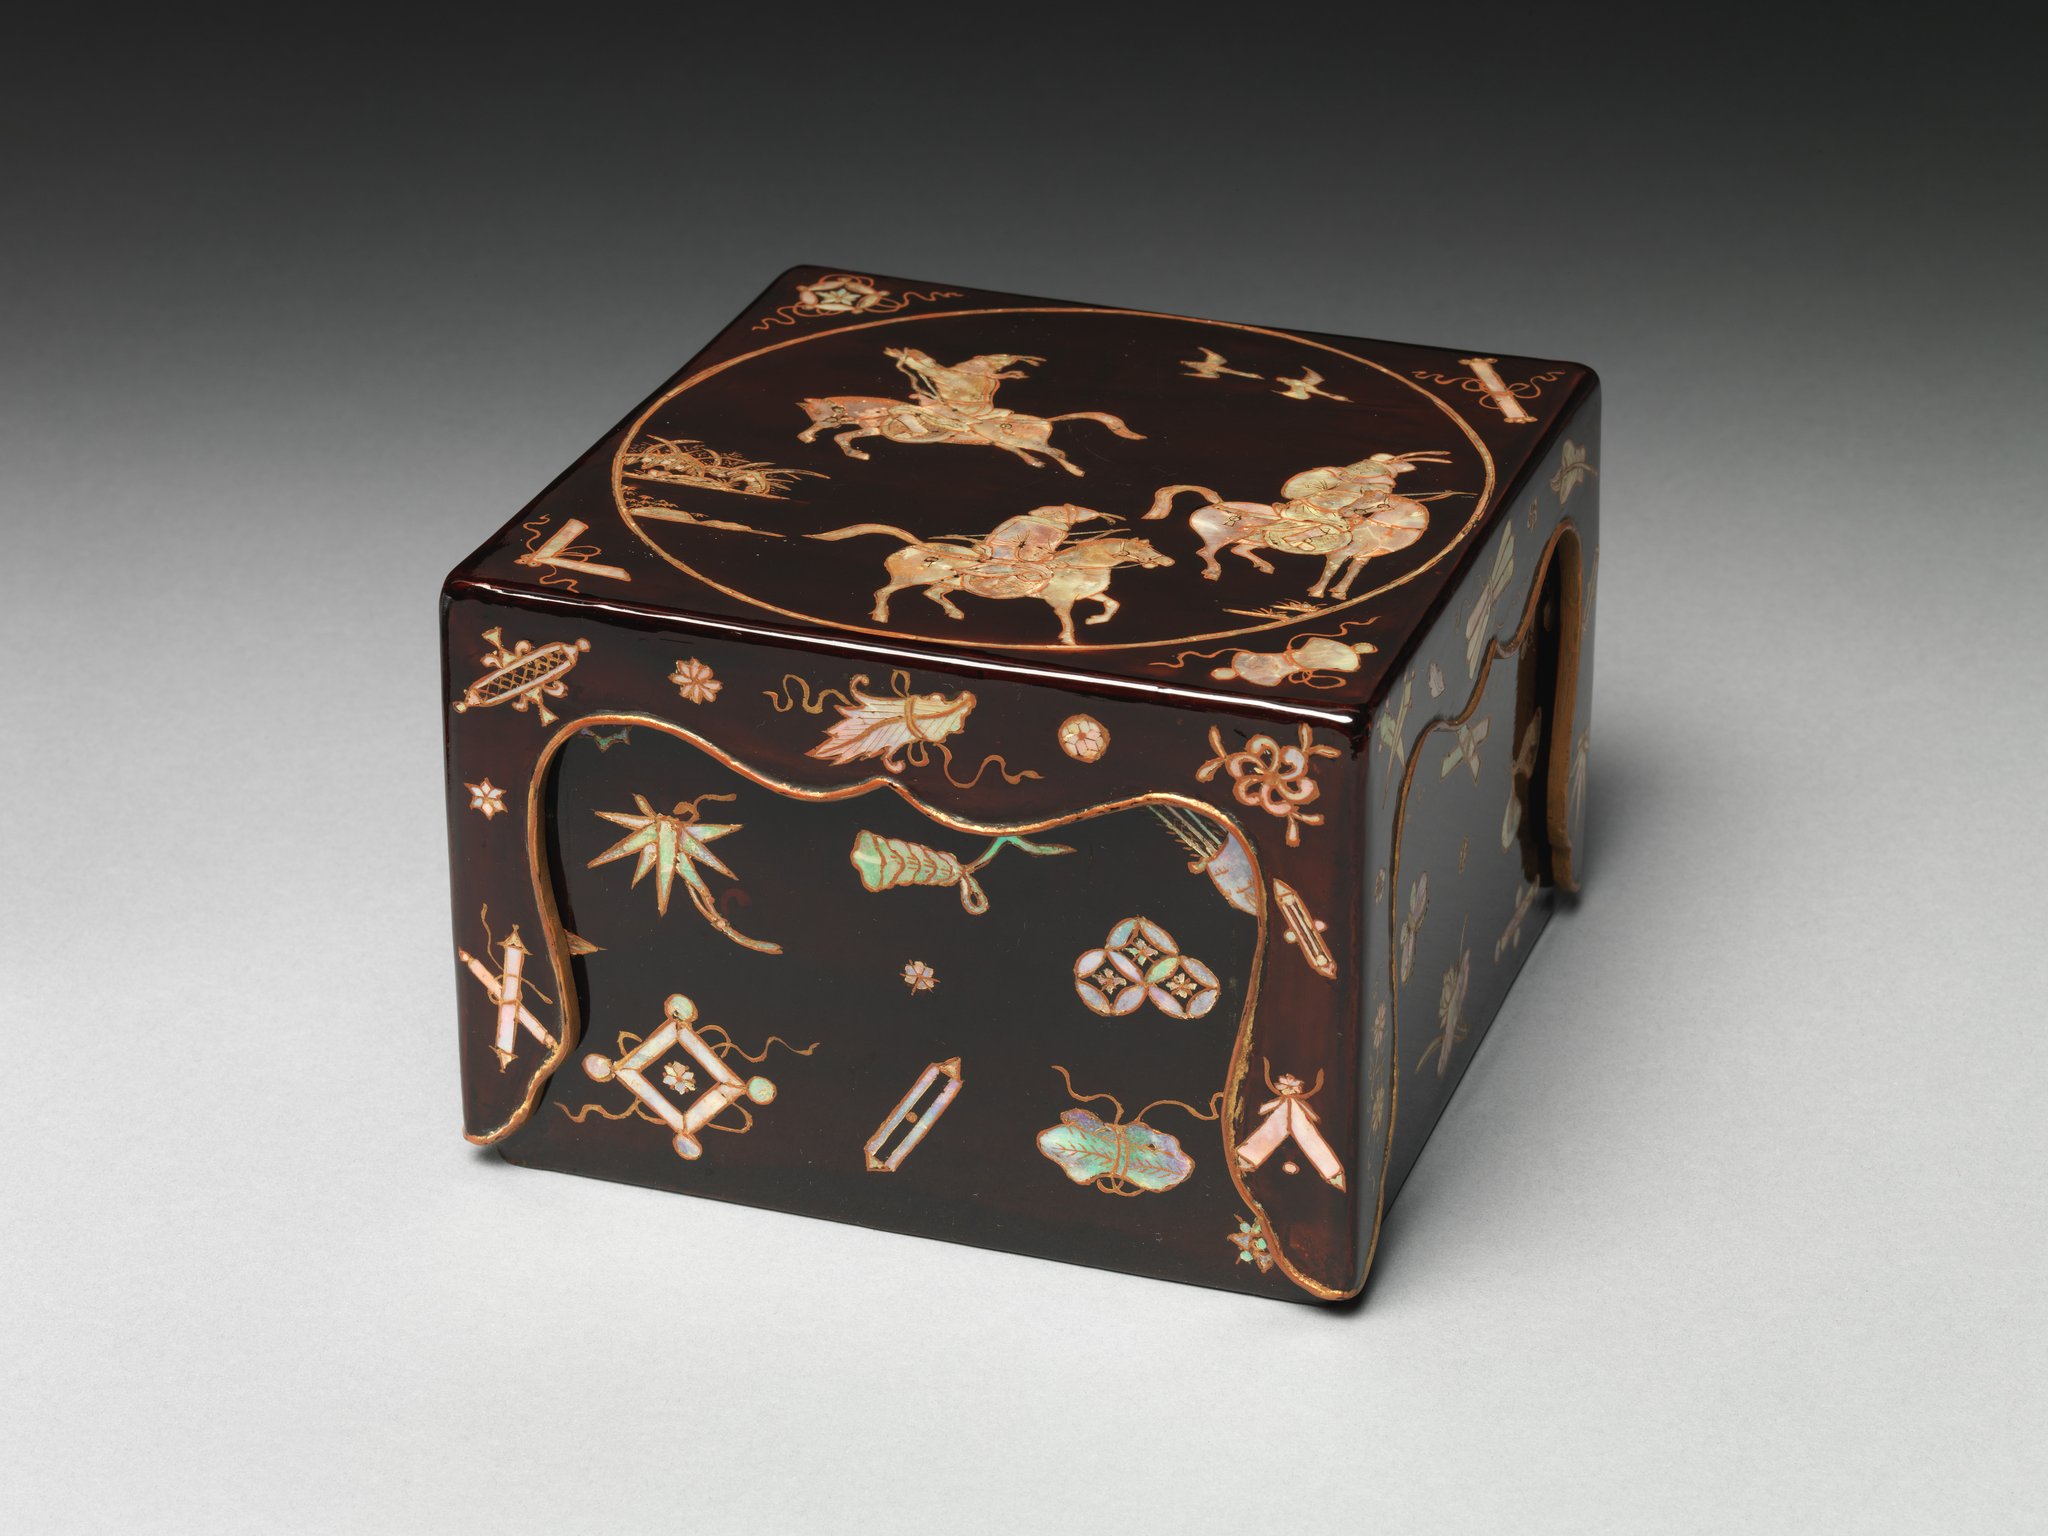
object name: seal box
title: Seal Box with Hunters on Horseback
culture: japanese or ryukyuan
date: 1601-1800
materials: gold, lacquer, mother of pearl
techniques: inlay, painting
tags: horses